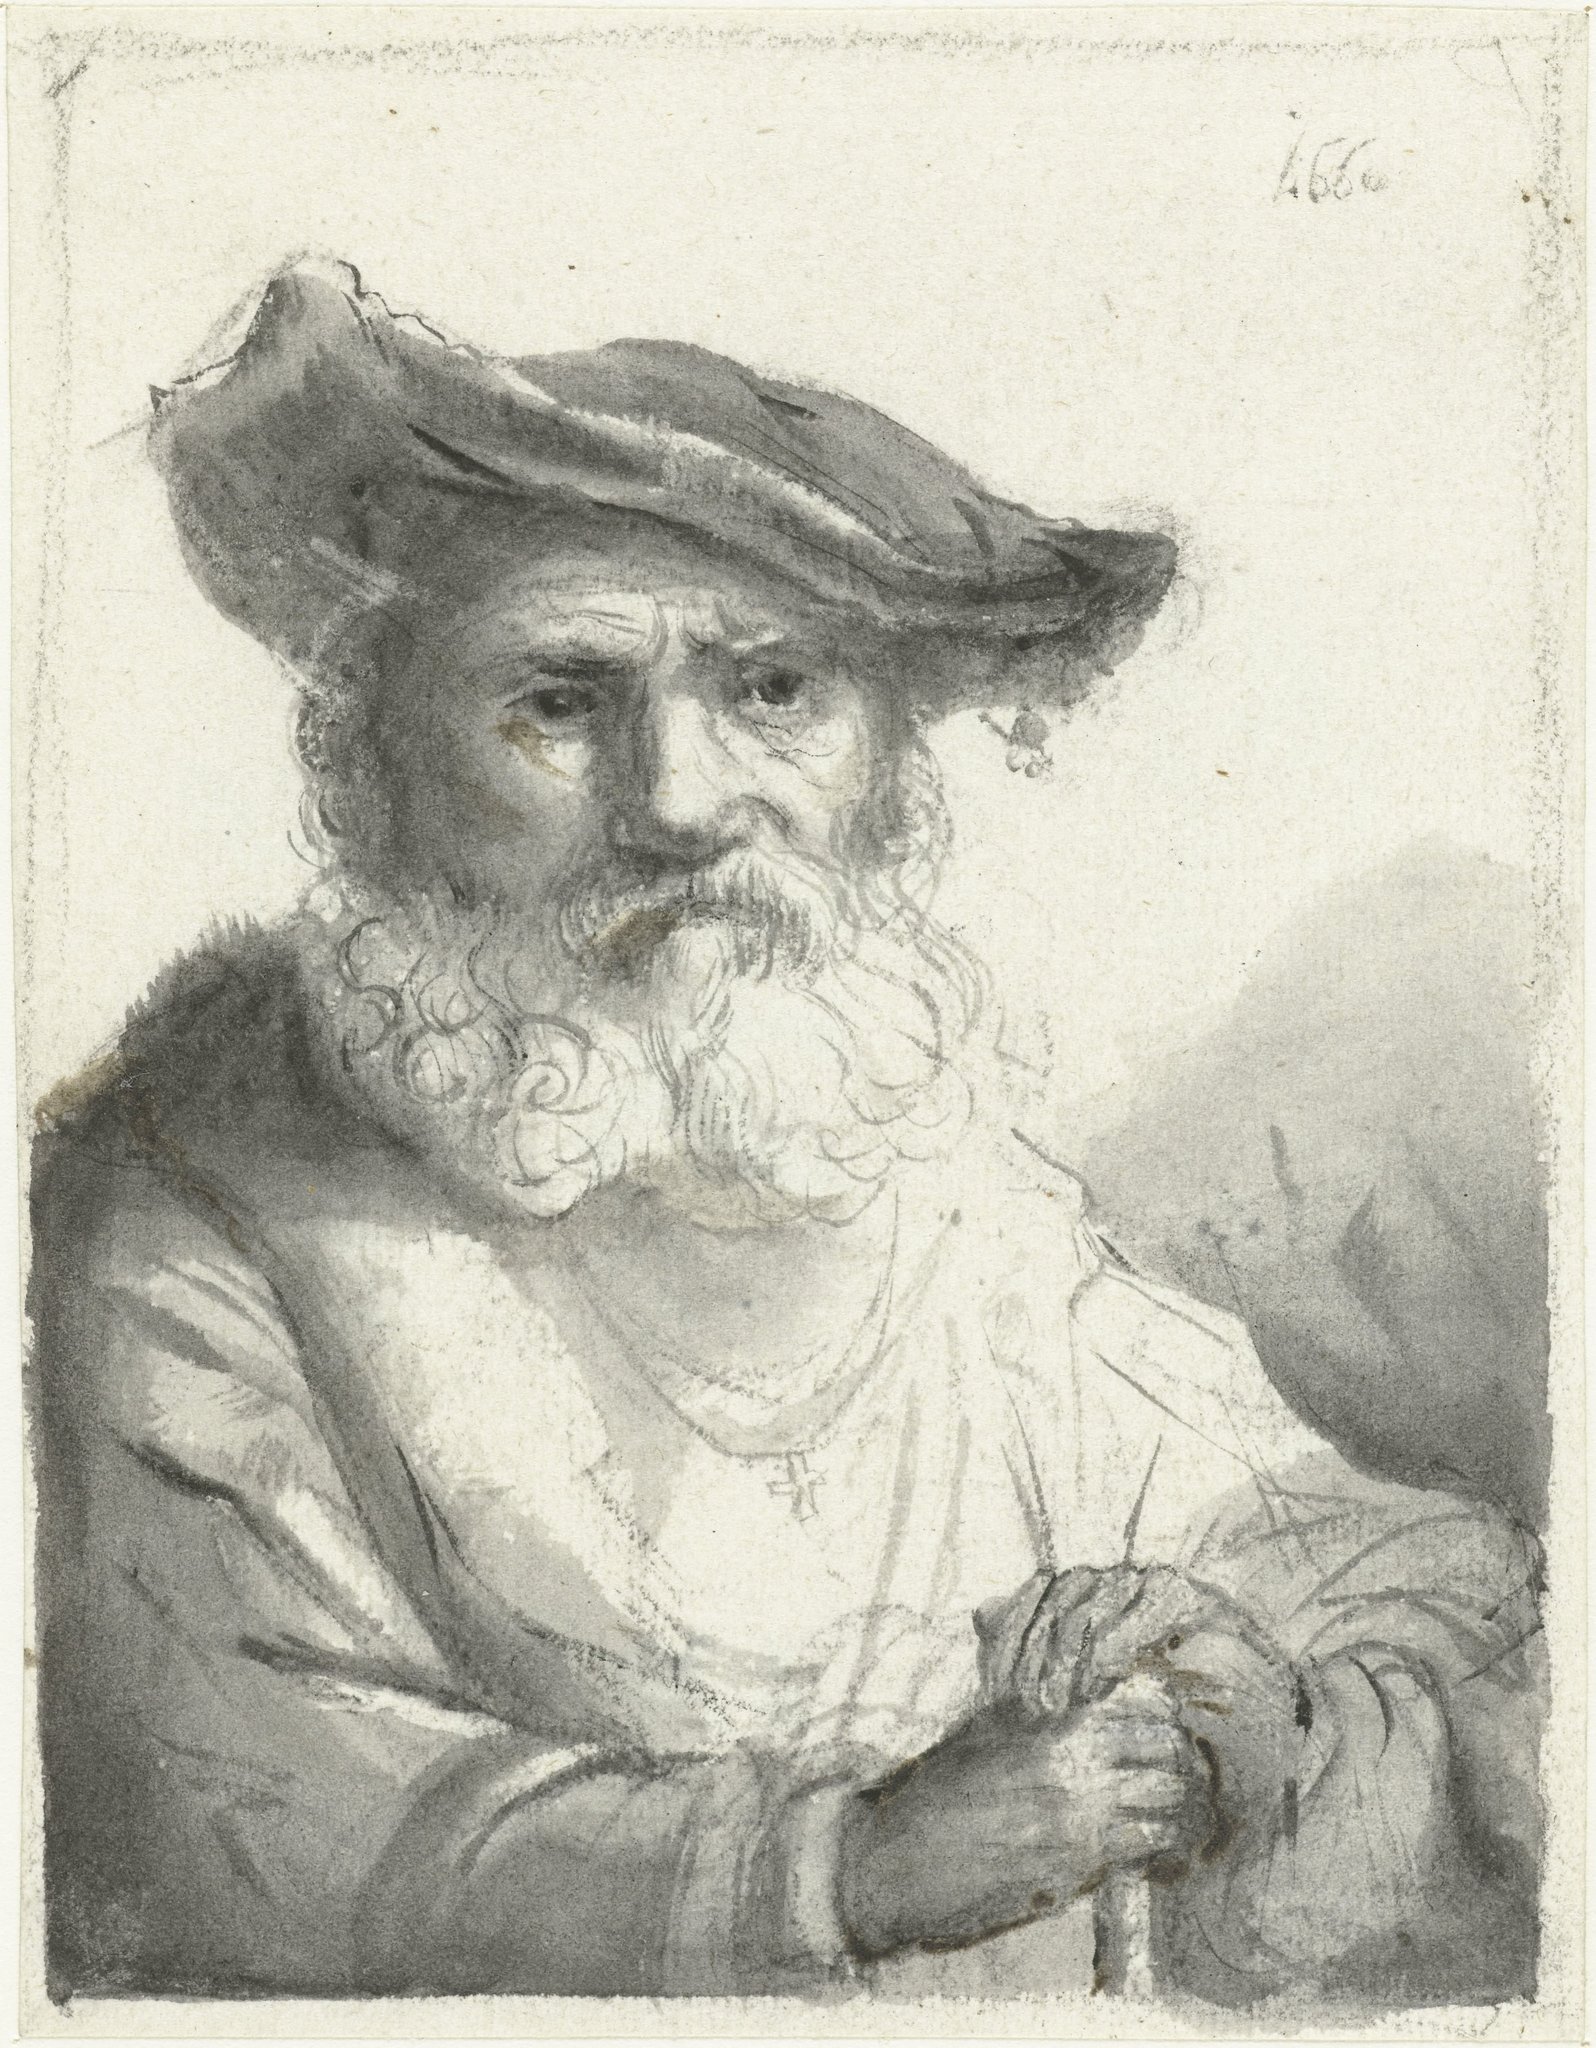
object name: drawing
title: Kop van een oude, bebaarde man met een fluwelen baret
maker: moses ter borch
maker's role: draughtsman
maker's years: 1645-1667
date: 1660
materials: chalk, ink, paper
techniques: brush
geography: zwolle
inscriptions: date: ‘1660’, annotation: ‘naar Bol / B.9’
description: Naar ets van Ferdinand Bol (Oude man met baard en fluwelen baret), Bar. 9, 1642.